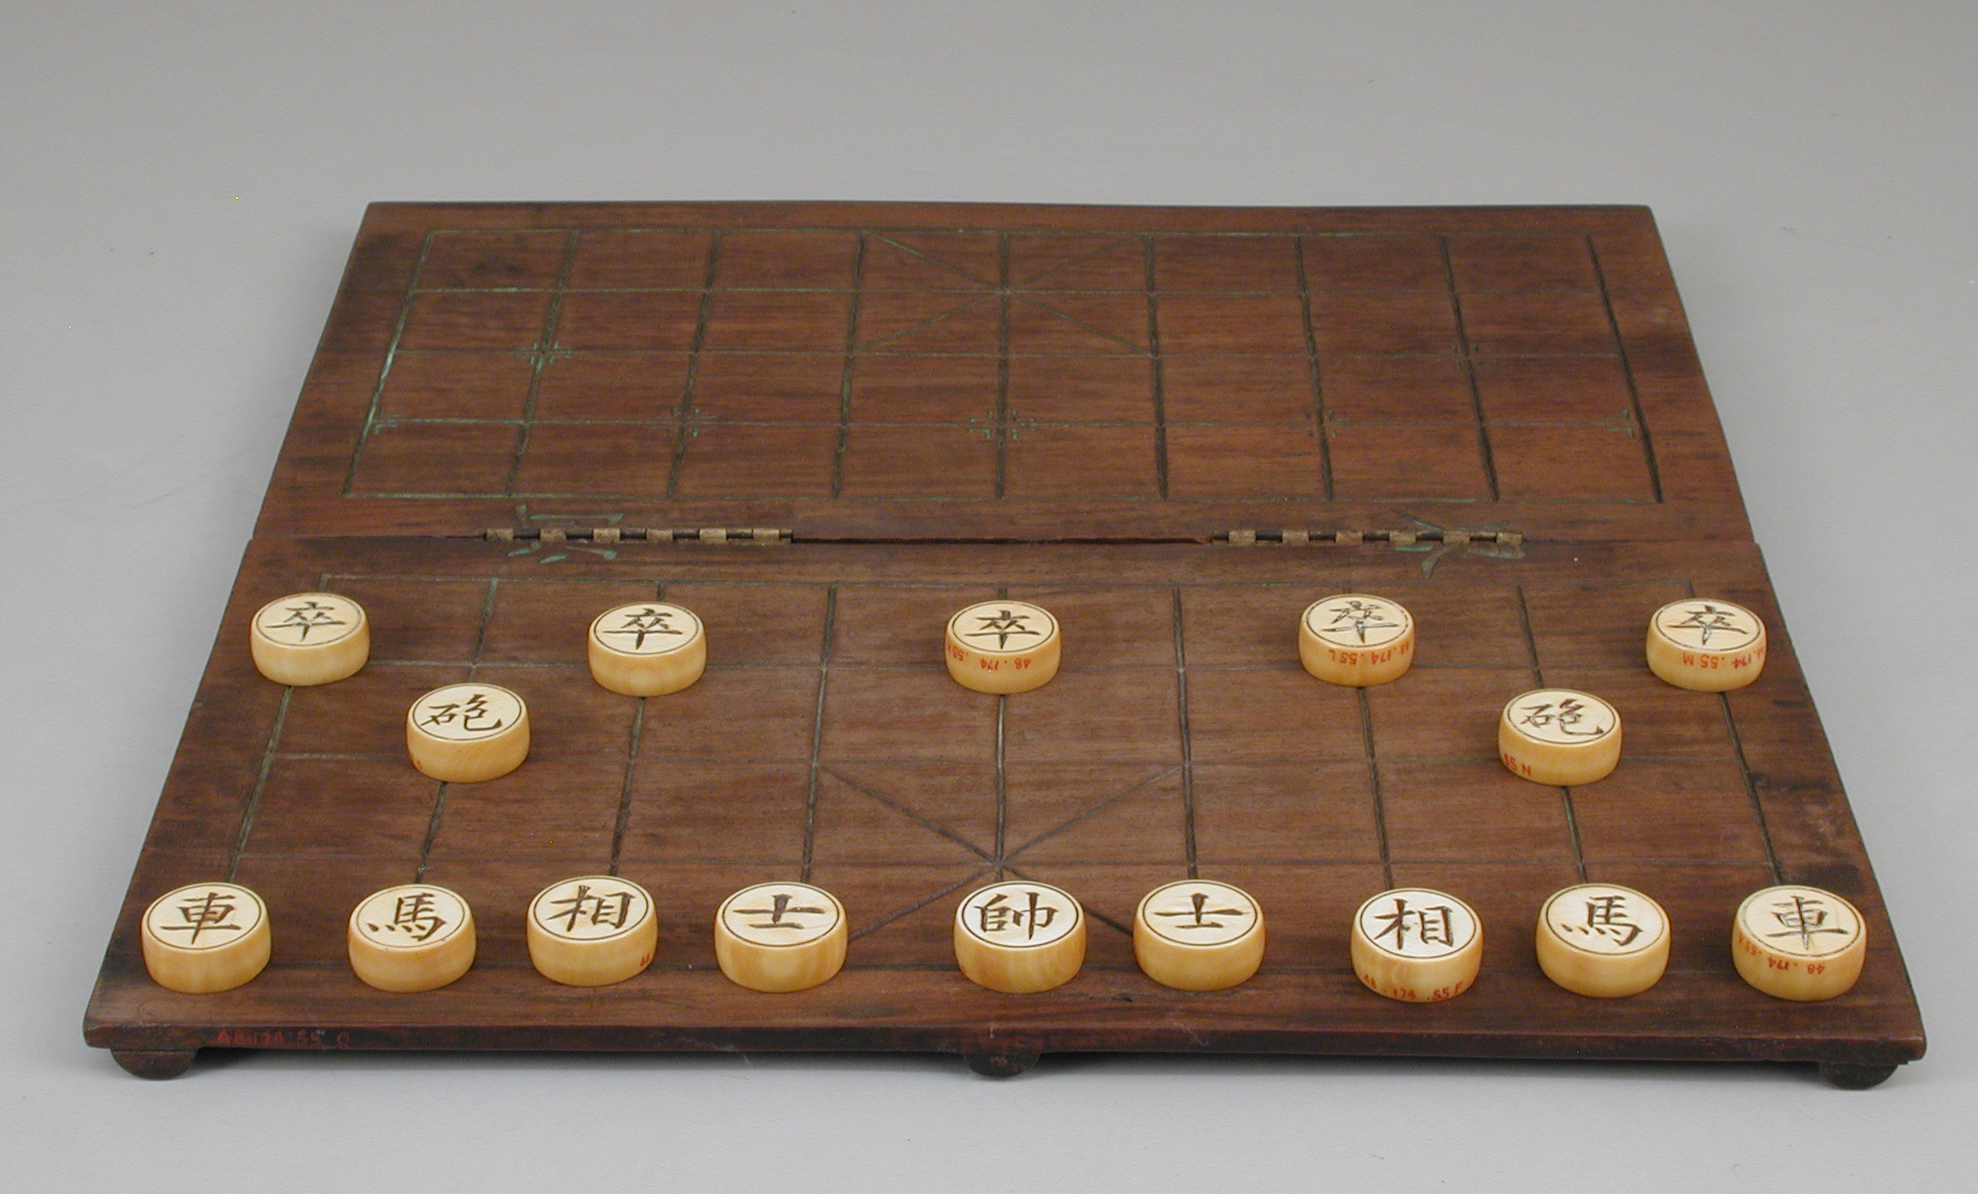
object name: chessman and box board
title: Chessmen (30) and board and box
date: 1701-1900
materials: ivory, wood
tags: chess